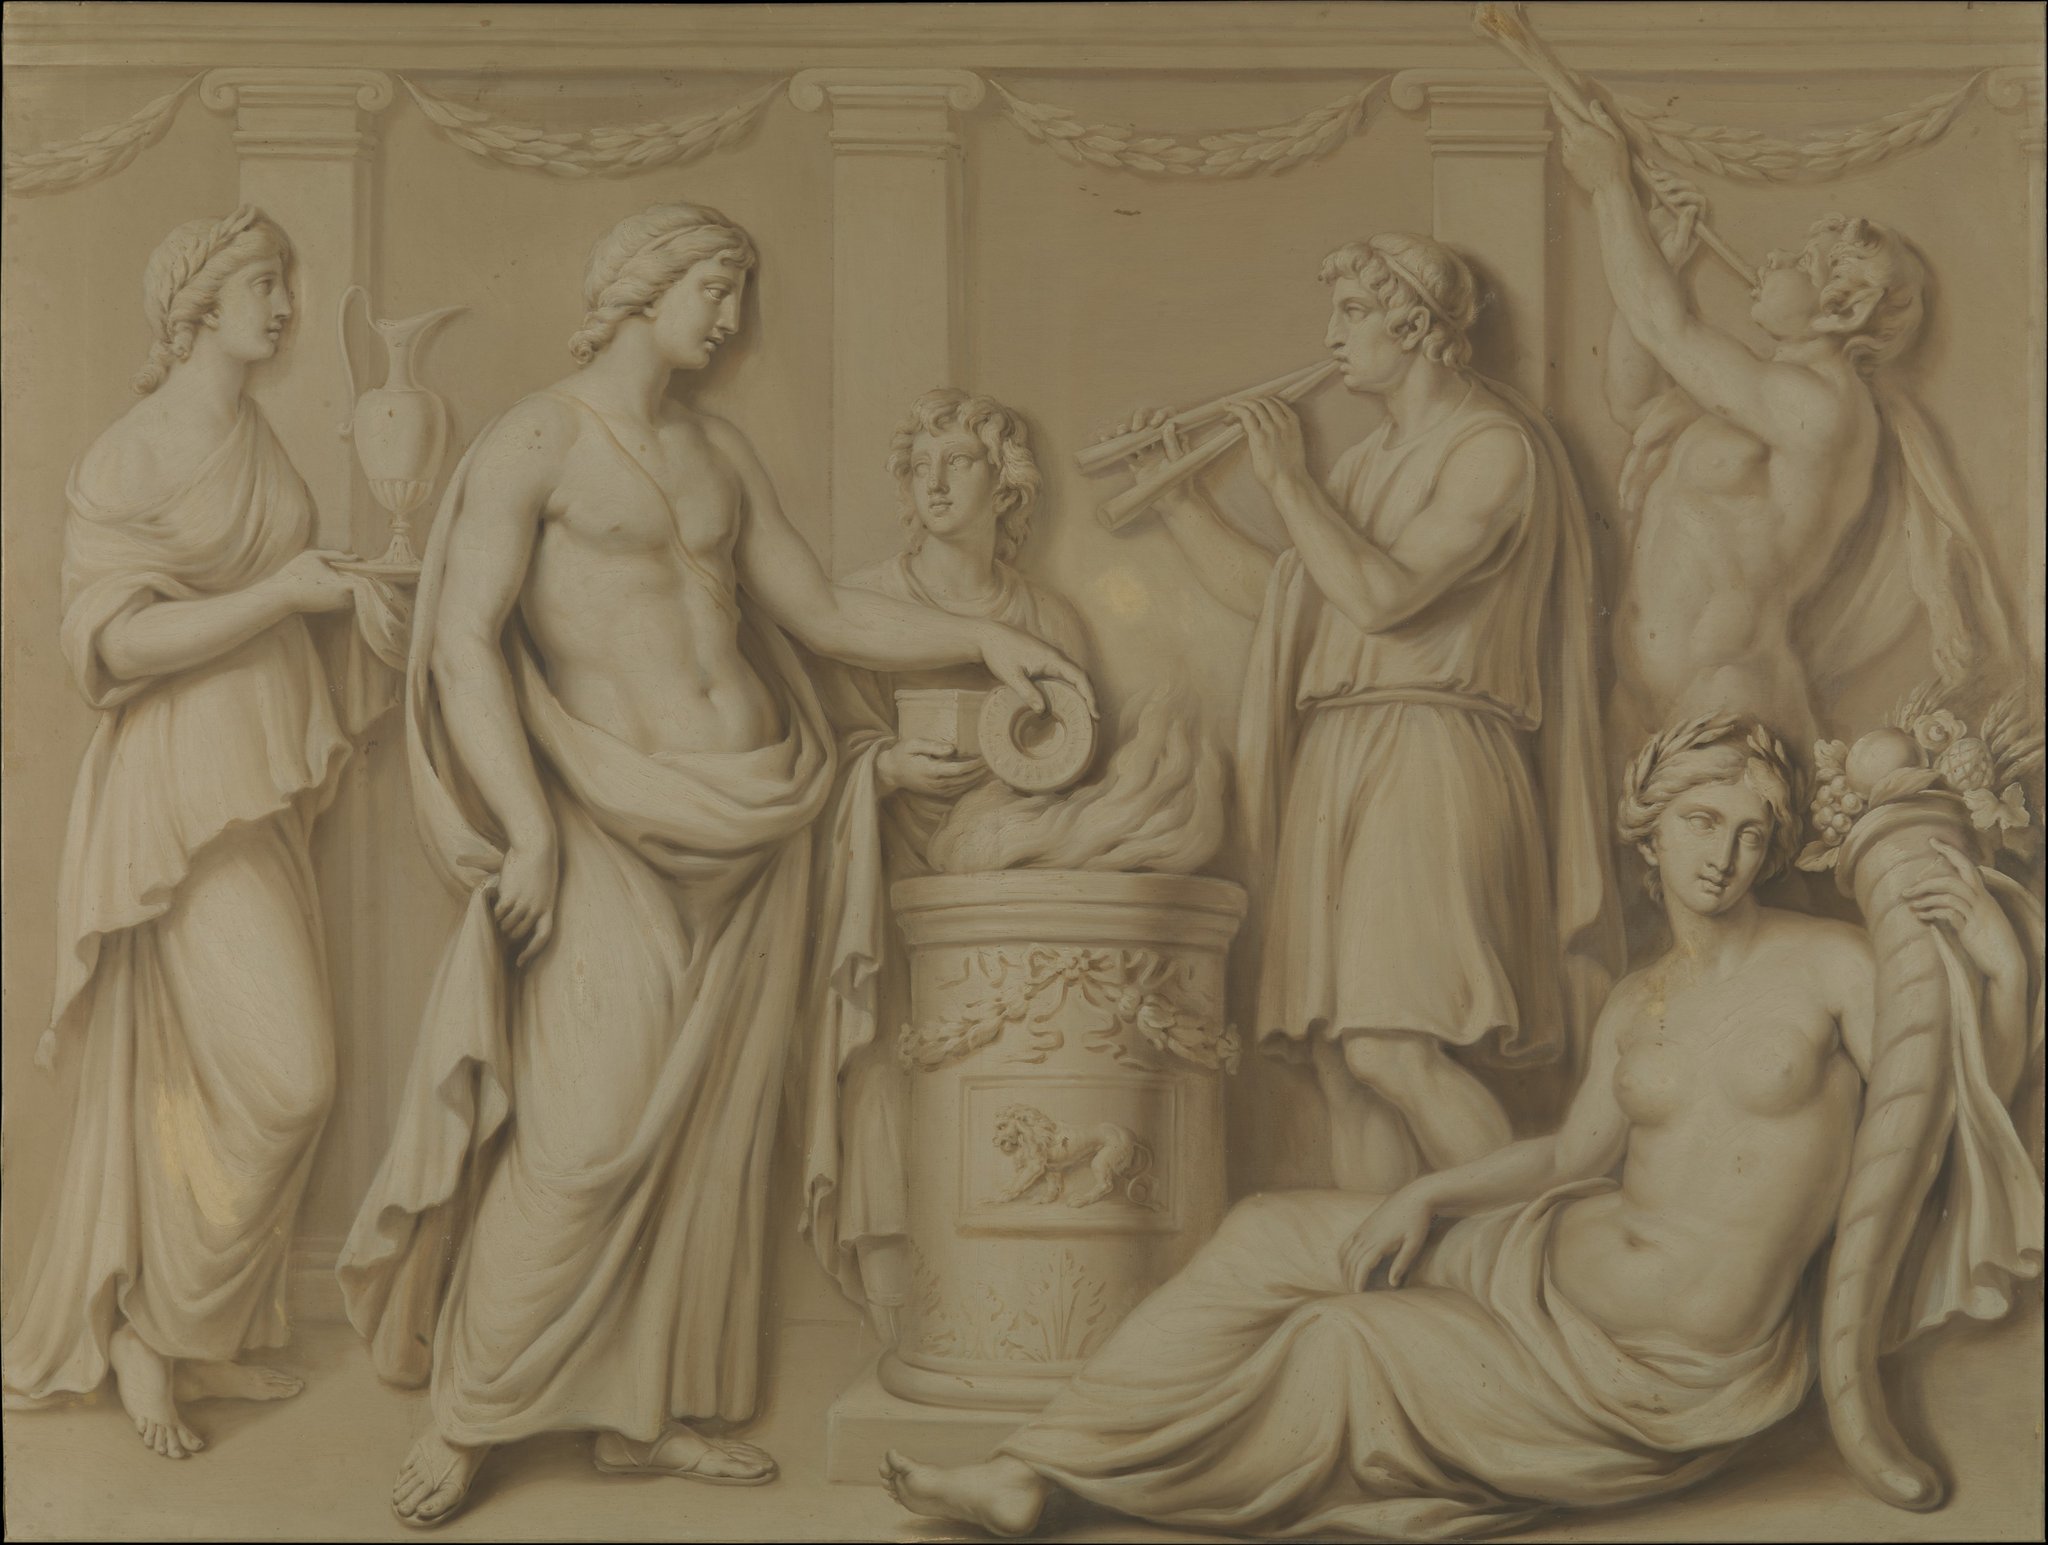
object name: overmantel painting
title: Ceremonial scene with Abundance and Piping Pan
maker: adam partnership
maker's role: maker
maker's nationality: british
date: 1765-1766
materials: canvas, oil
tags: musical instruments,men,female nudes,cornucopia,ceremony,musicians